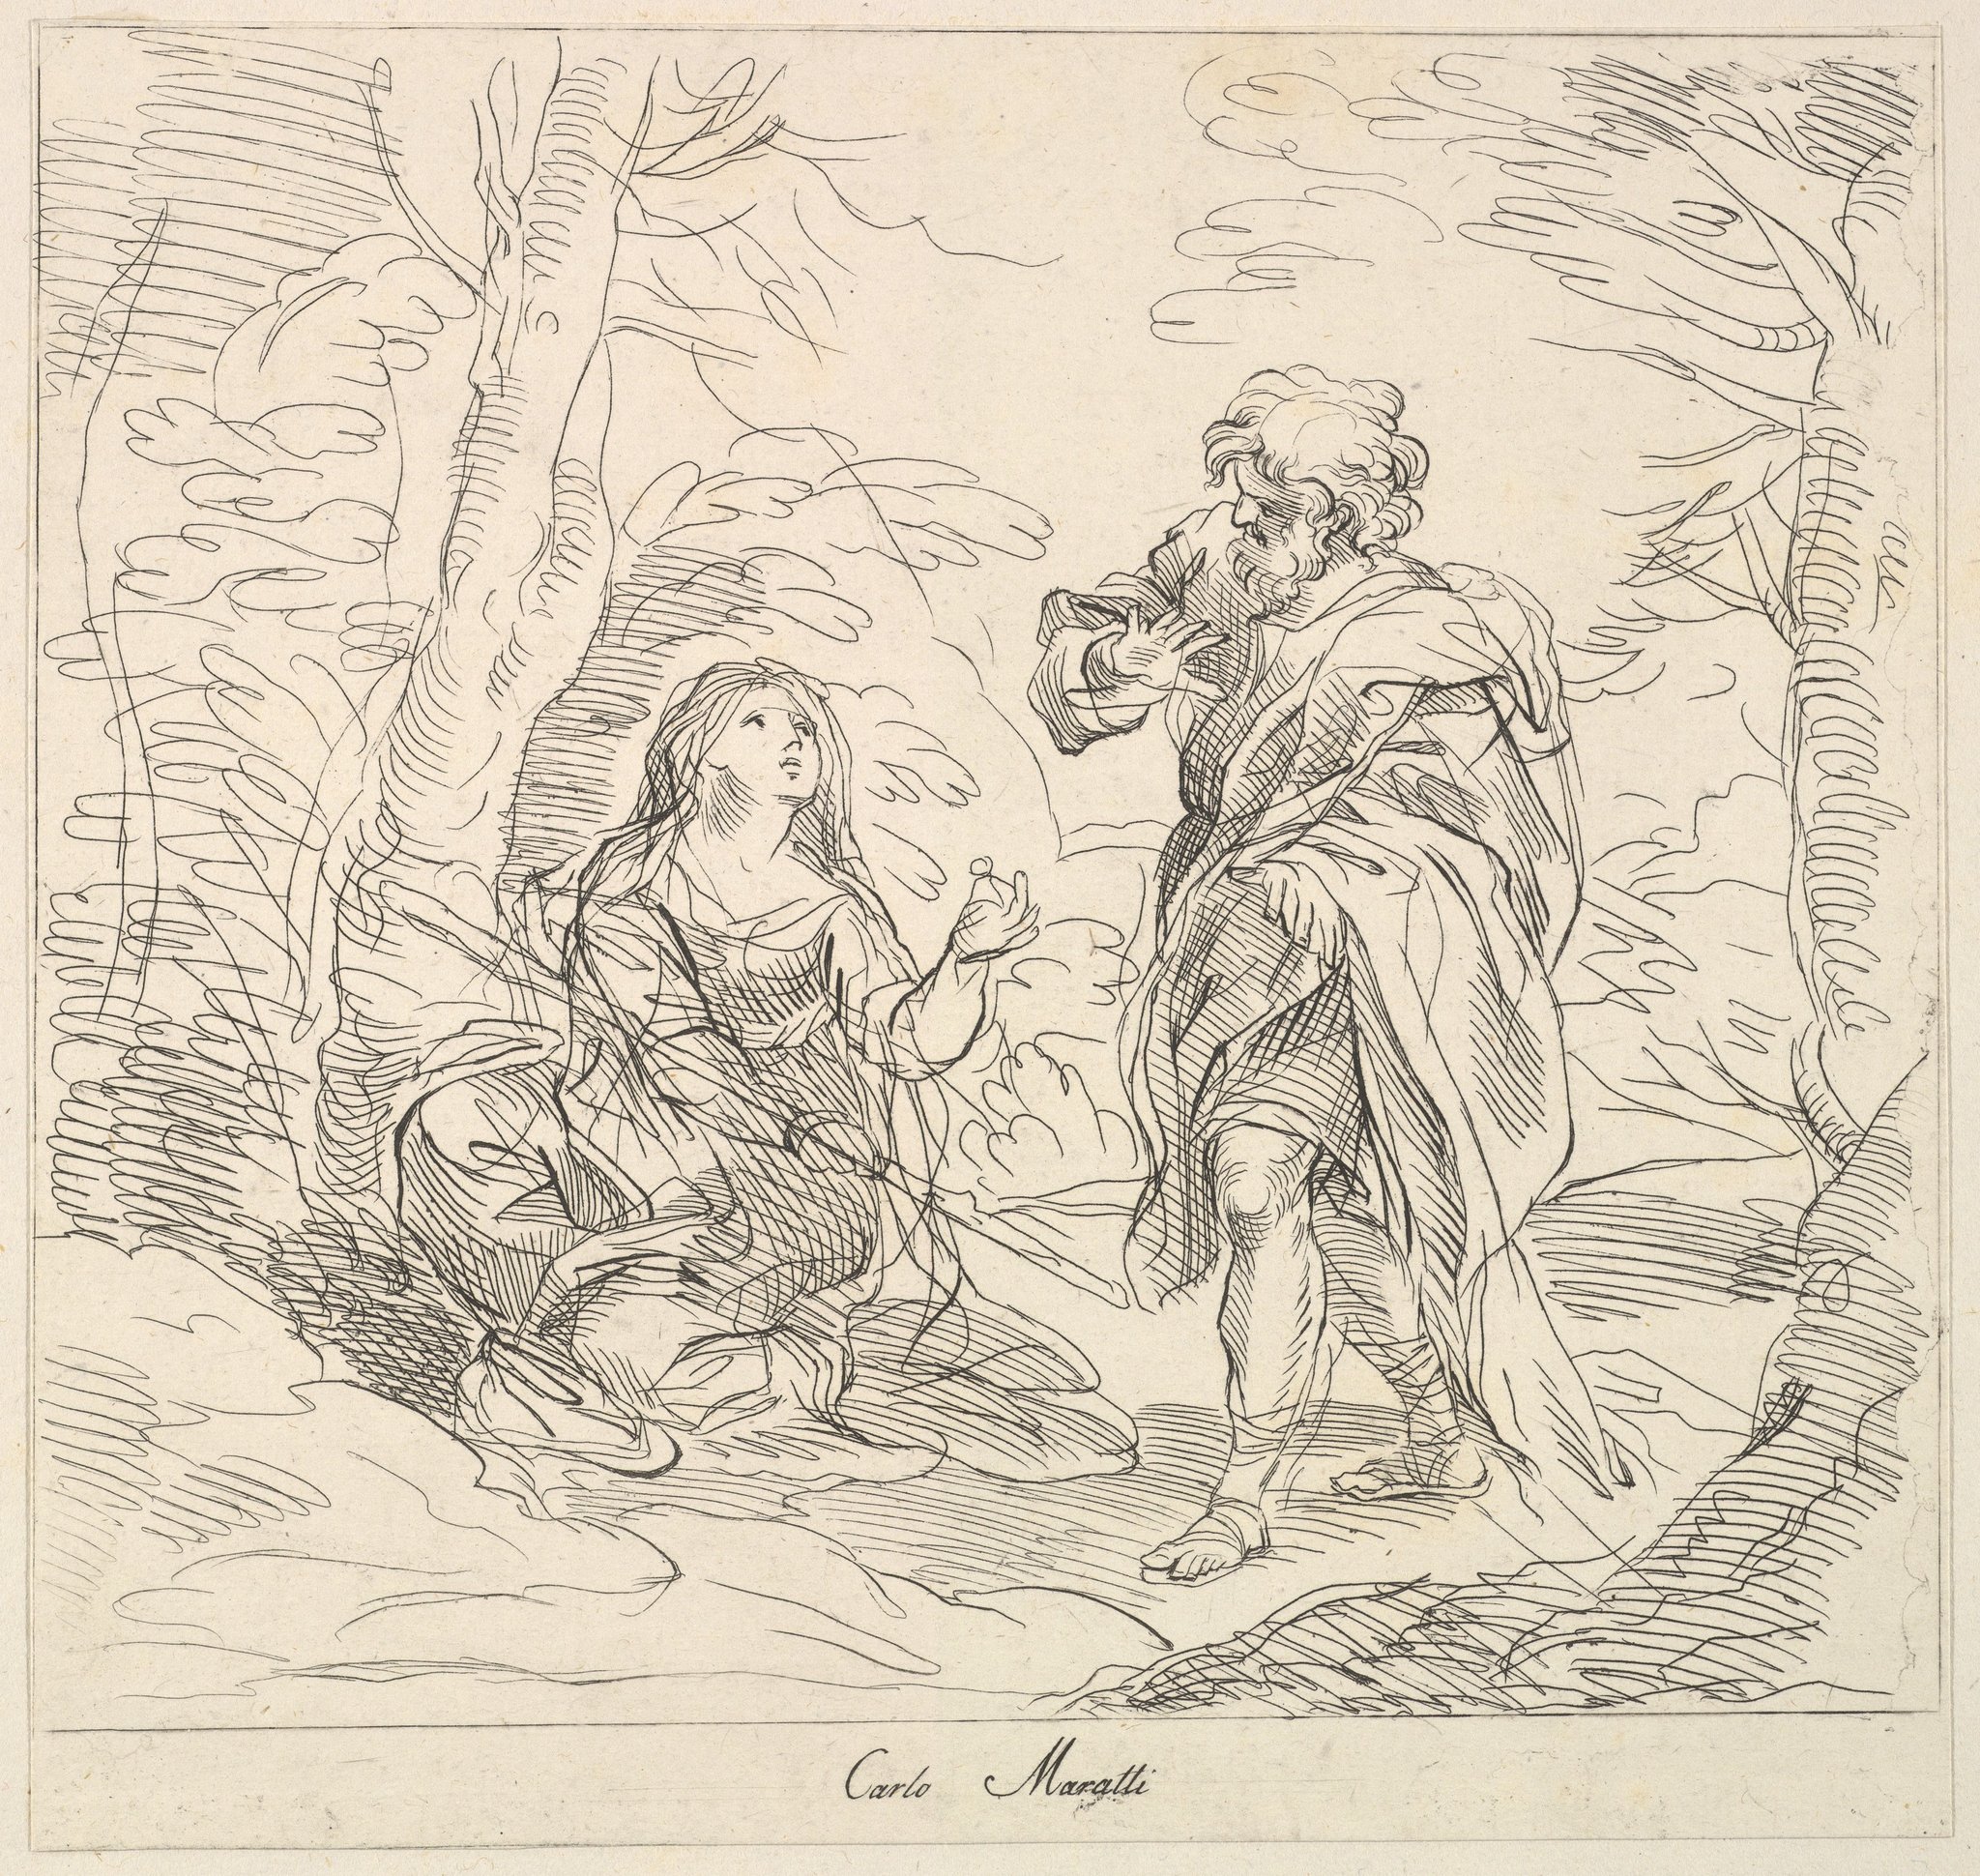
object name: print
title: Seated woman and Bearded Man in a Landscape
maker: giuseppe canale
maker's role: artist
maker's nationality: italian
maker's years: 1725-1802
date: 1740-1802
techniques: etching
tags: men,women